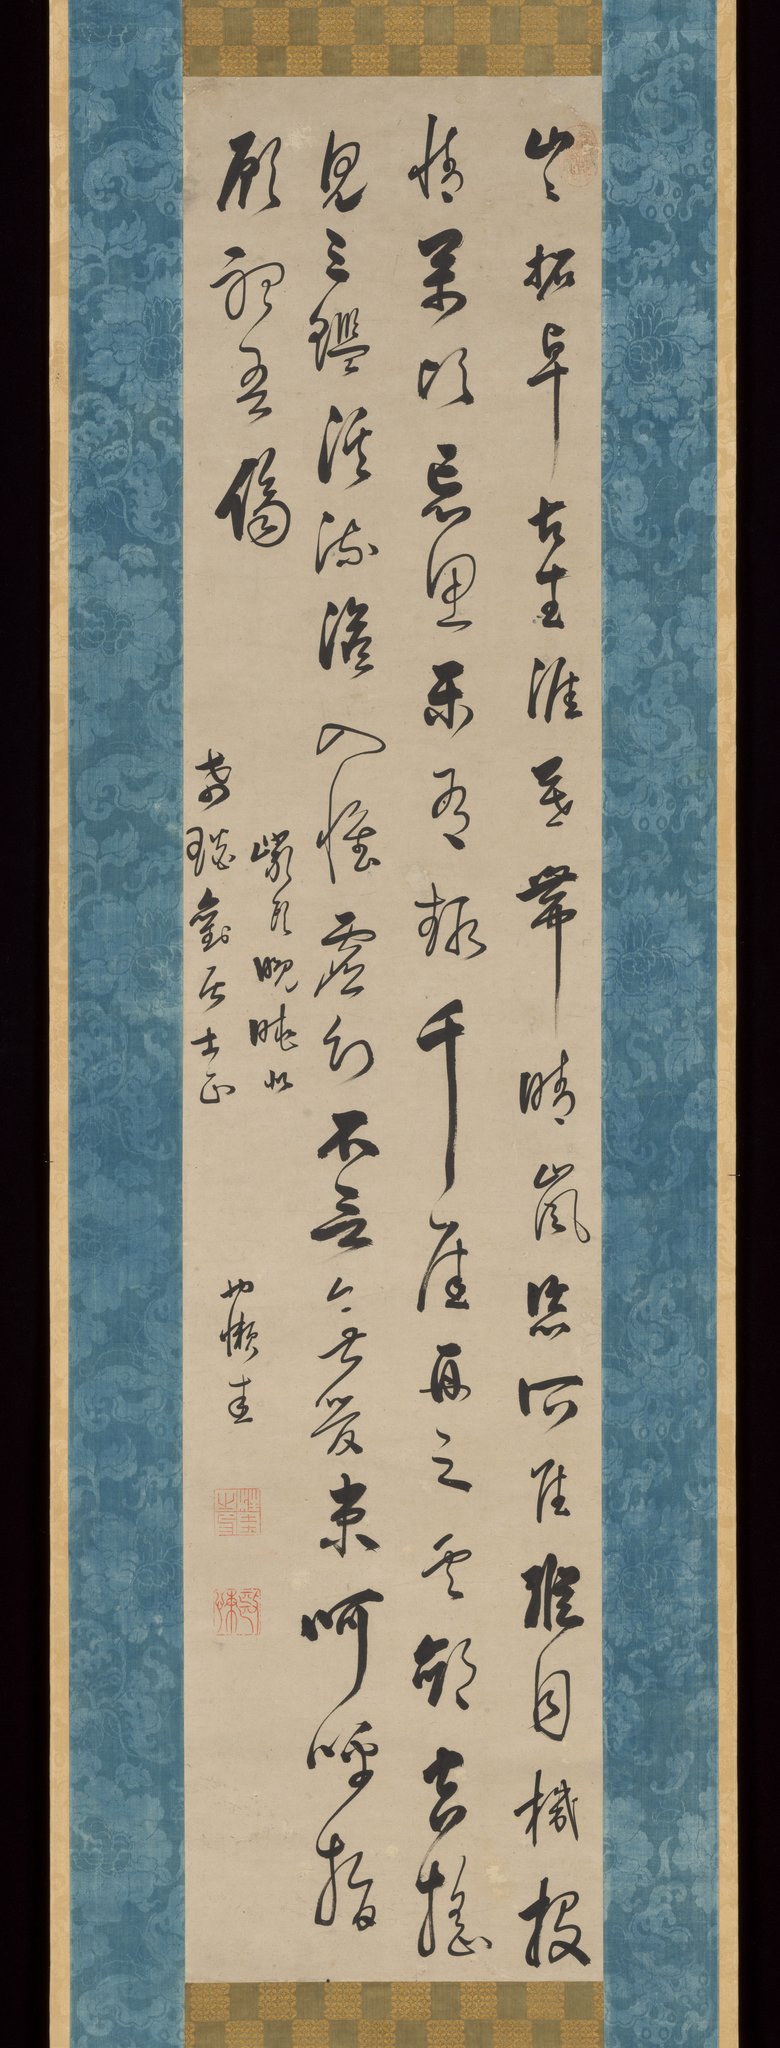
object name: hanging scroll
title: Chinese Poem on an Imaginary Landscape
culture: japanese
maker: yelan xinggui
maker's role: artist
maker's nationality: chinese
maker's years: 1613-1651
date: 1601-1633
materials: ink, paper